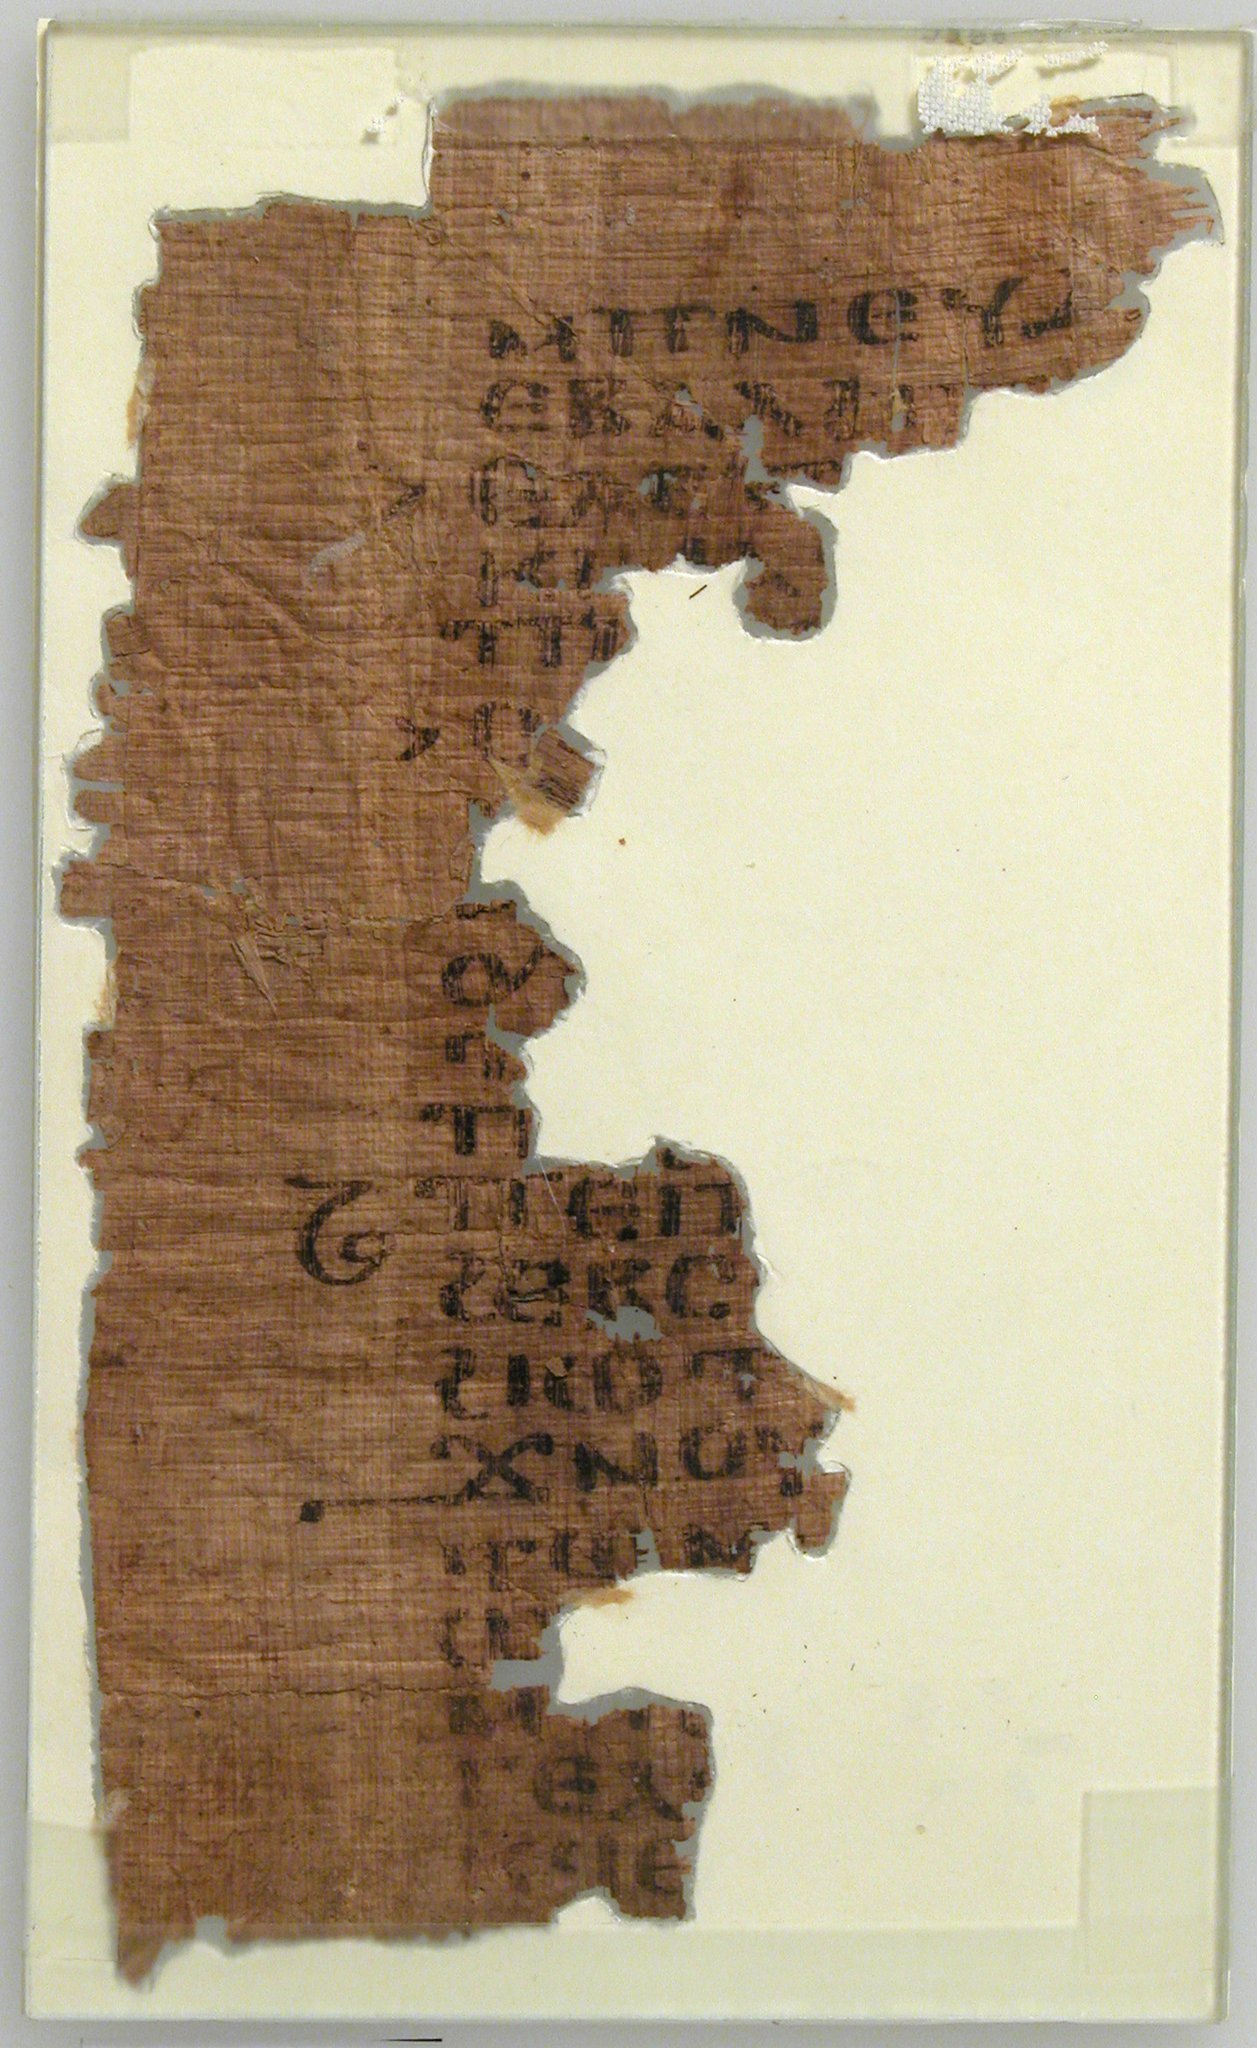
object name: fragment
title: Papyrus Fragment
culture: coptic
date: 301-700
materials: ink, papyrus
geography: egypt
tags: documents